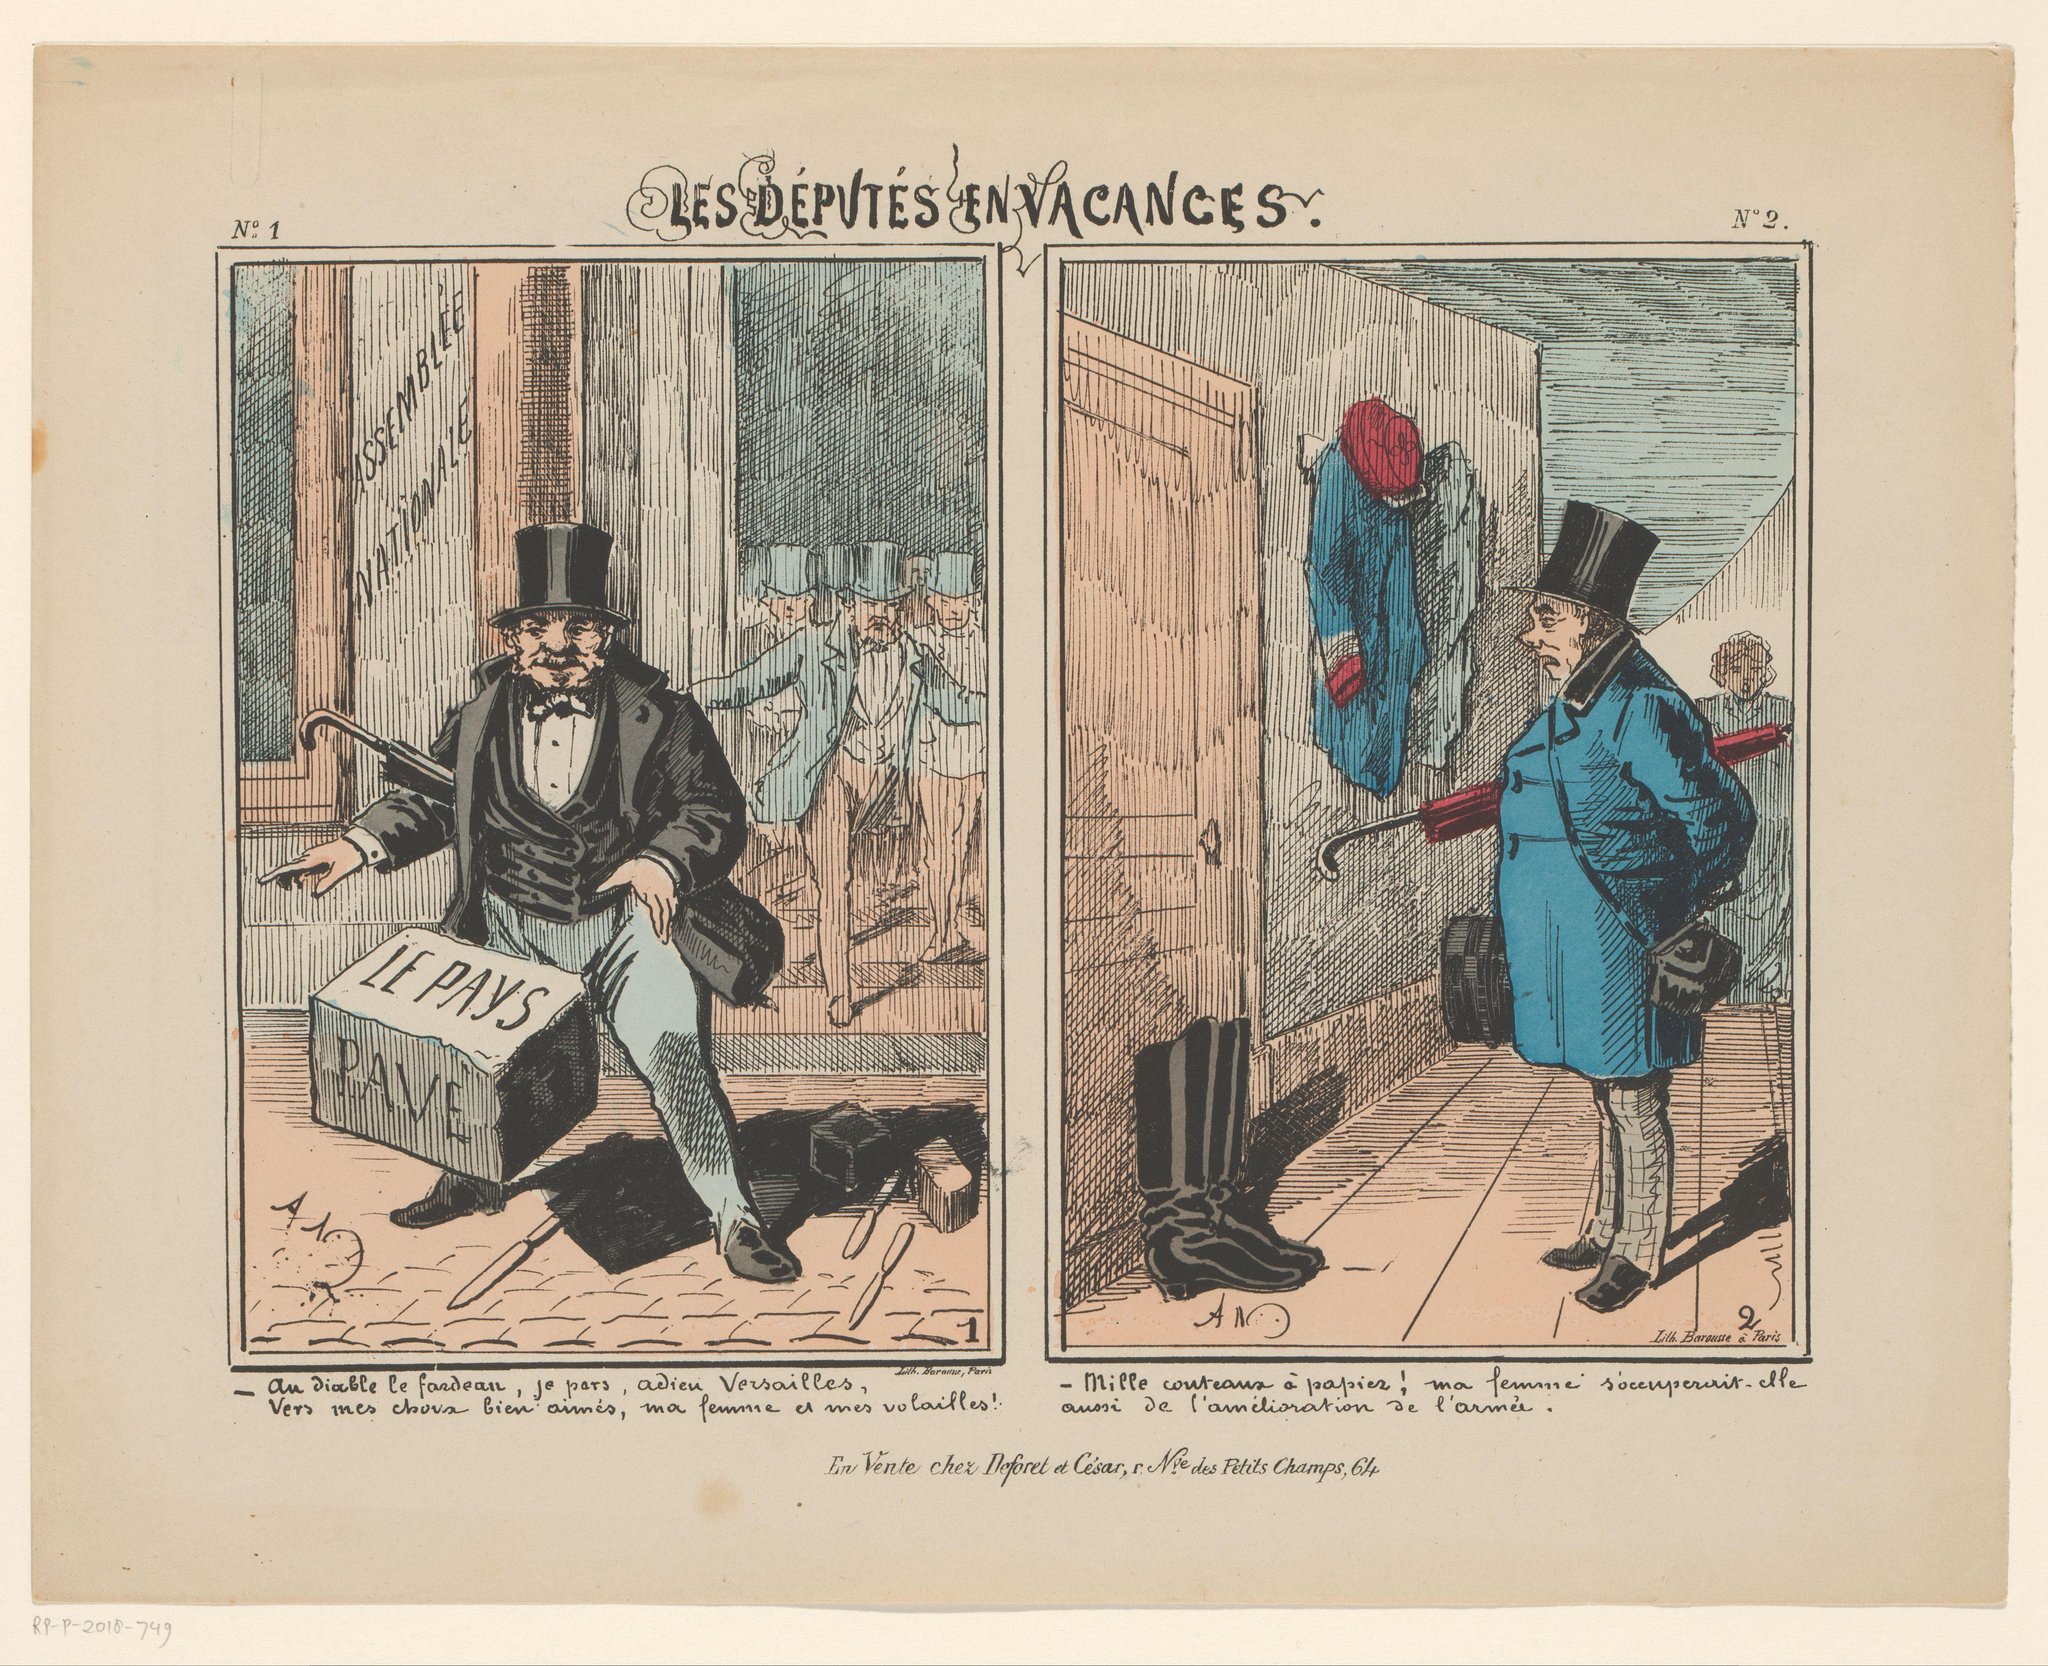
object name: print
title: Les Députés en Vacances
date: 1860-1880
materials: paper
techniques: hand coloring, lithograph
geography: paris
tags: member of parliament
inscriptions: collector's mark: Lugt 2228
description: Spotprent met twee voorstellingen (No 1 en 2) van leden van het Assemblée nationale op vakantie. Mogelijk gerelateerd aan de Parijse Commune 1871. Zie ook de pendant.